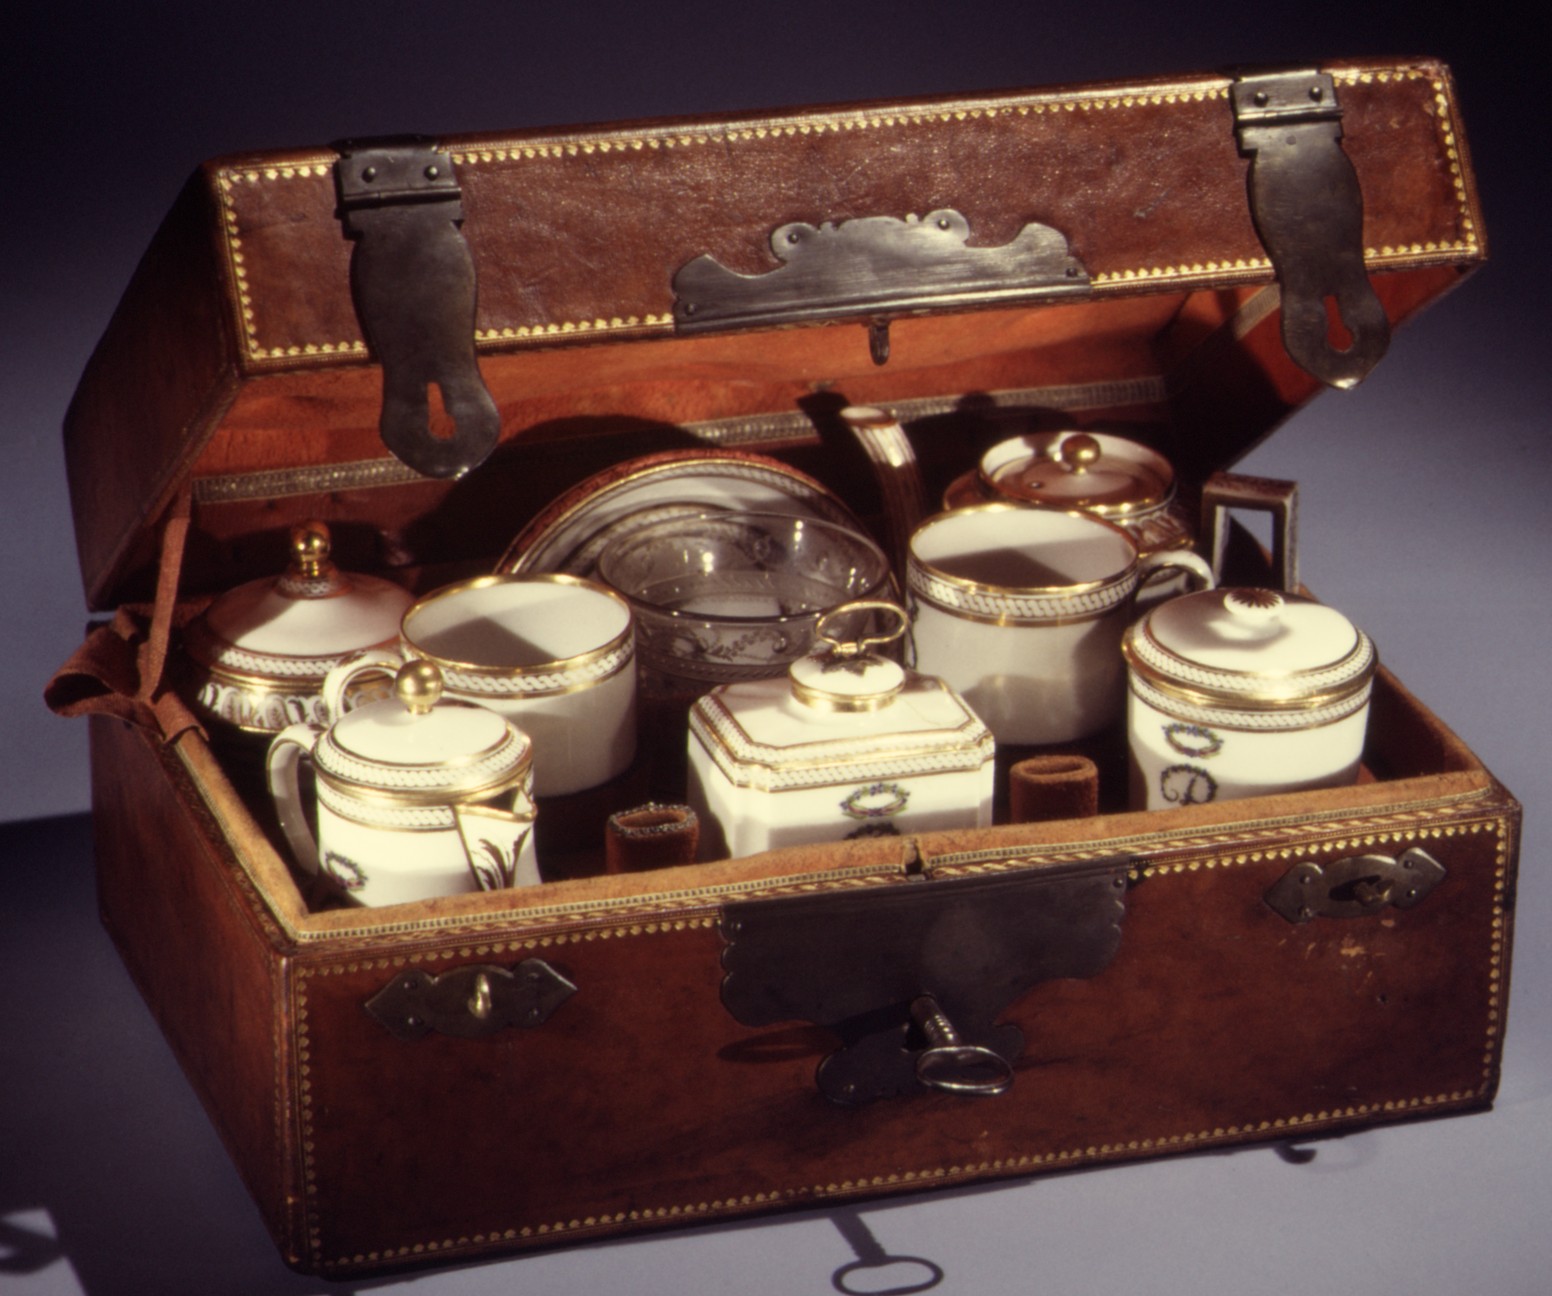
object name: traveling service case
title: Case for a traveling service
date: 1788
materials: leather